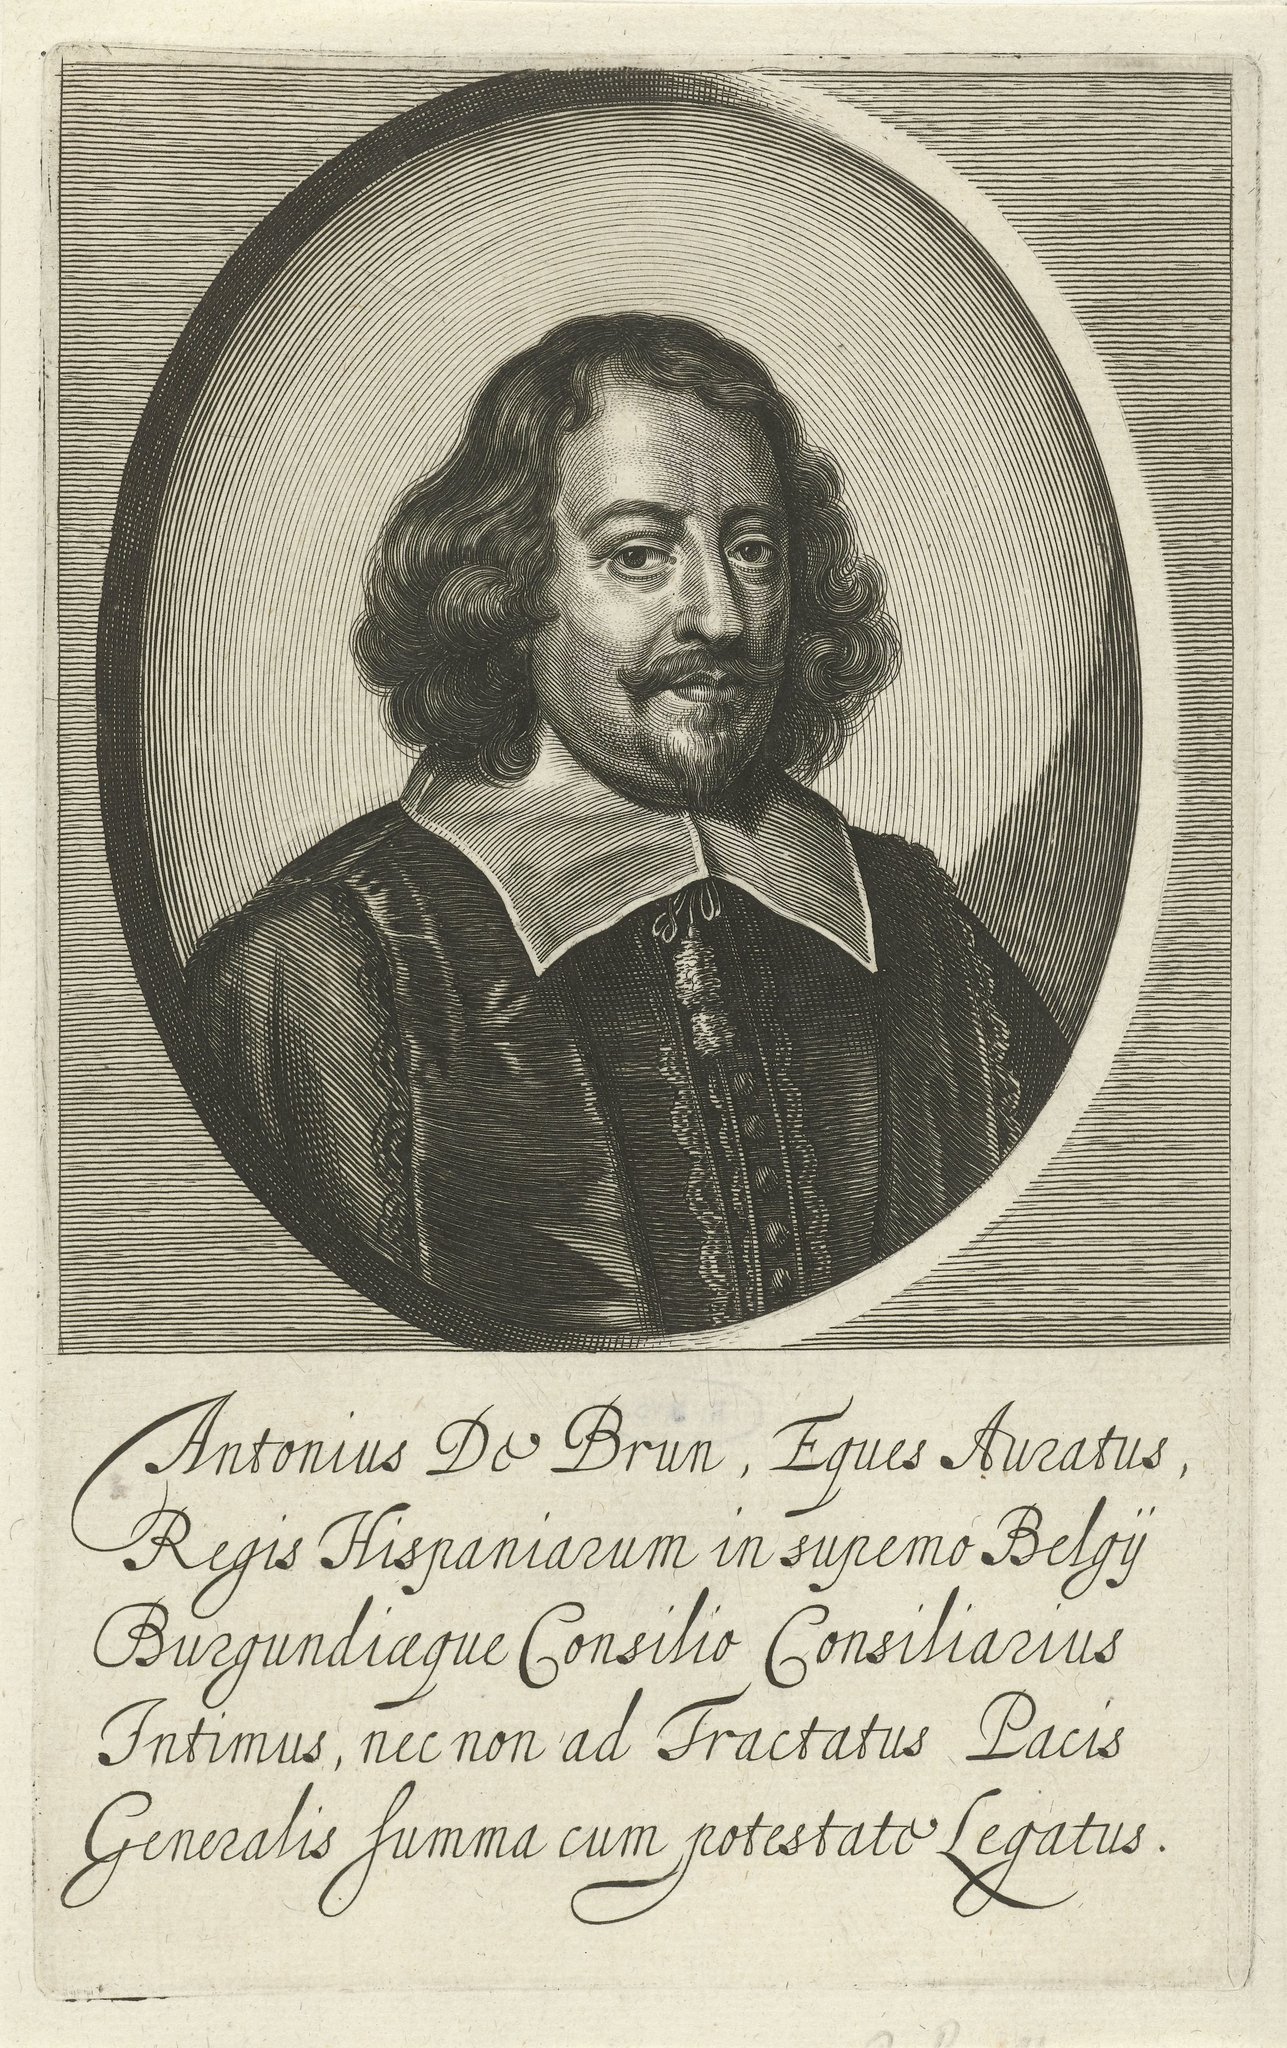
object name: print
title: Portret van Antoine Brun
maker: pieter holsteyn (ii)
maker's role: draughtsman, print maker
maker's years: 1614-1673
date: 1648-1670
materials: paper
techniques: engraving, etching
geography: northern netherlands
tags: antoine brun, vrede van münster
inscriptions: collector's mark: Lugt 2228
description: Buste naar rechts van Antoine Brun in een ovaal. Onder het portret vijf regels in het Latijn. Prent uit een serie portretten van ambassadeurs betrokken bij het vredesverdrag van Munster.